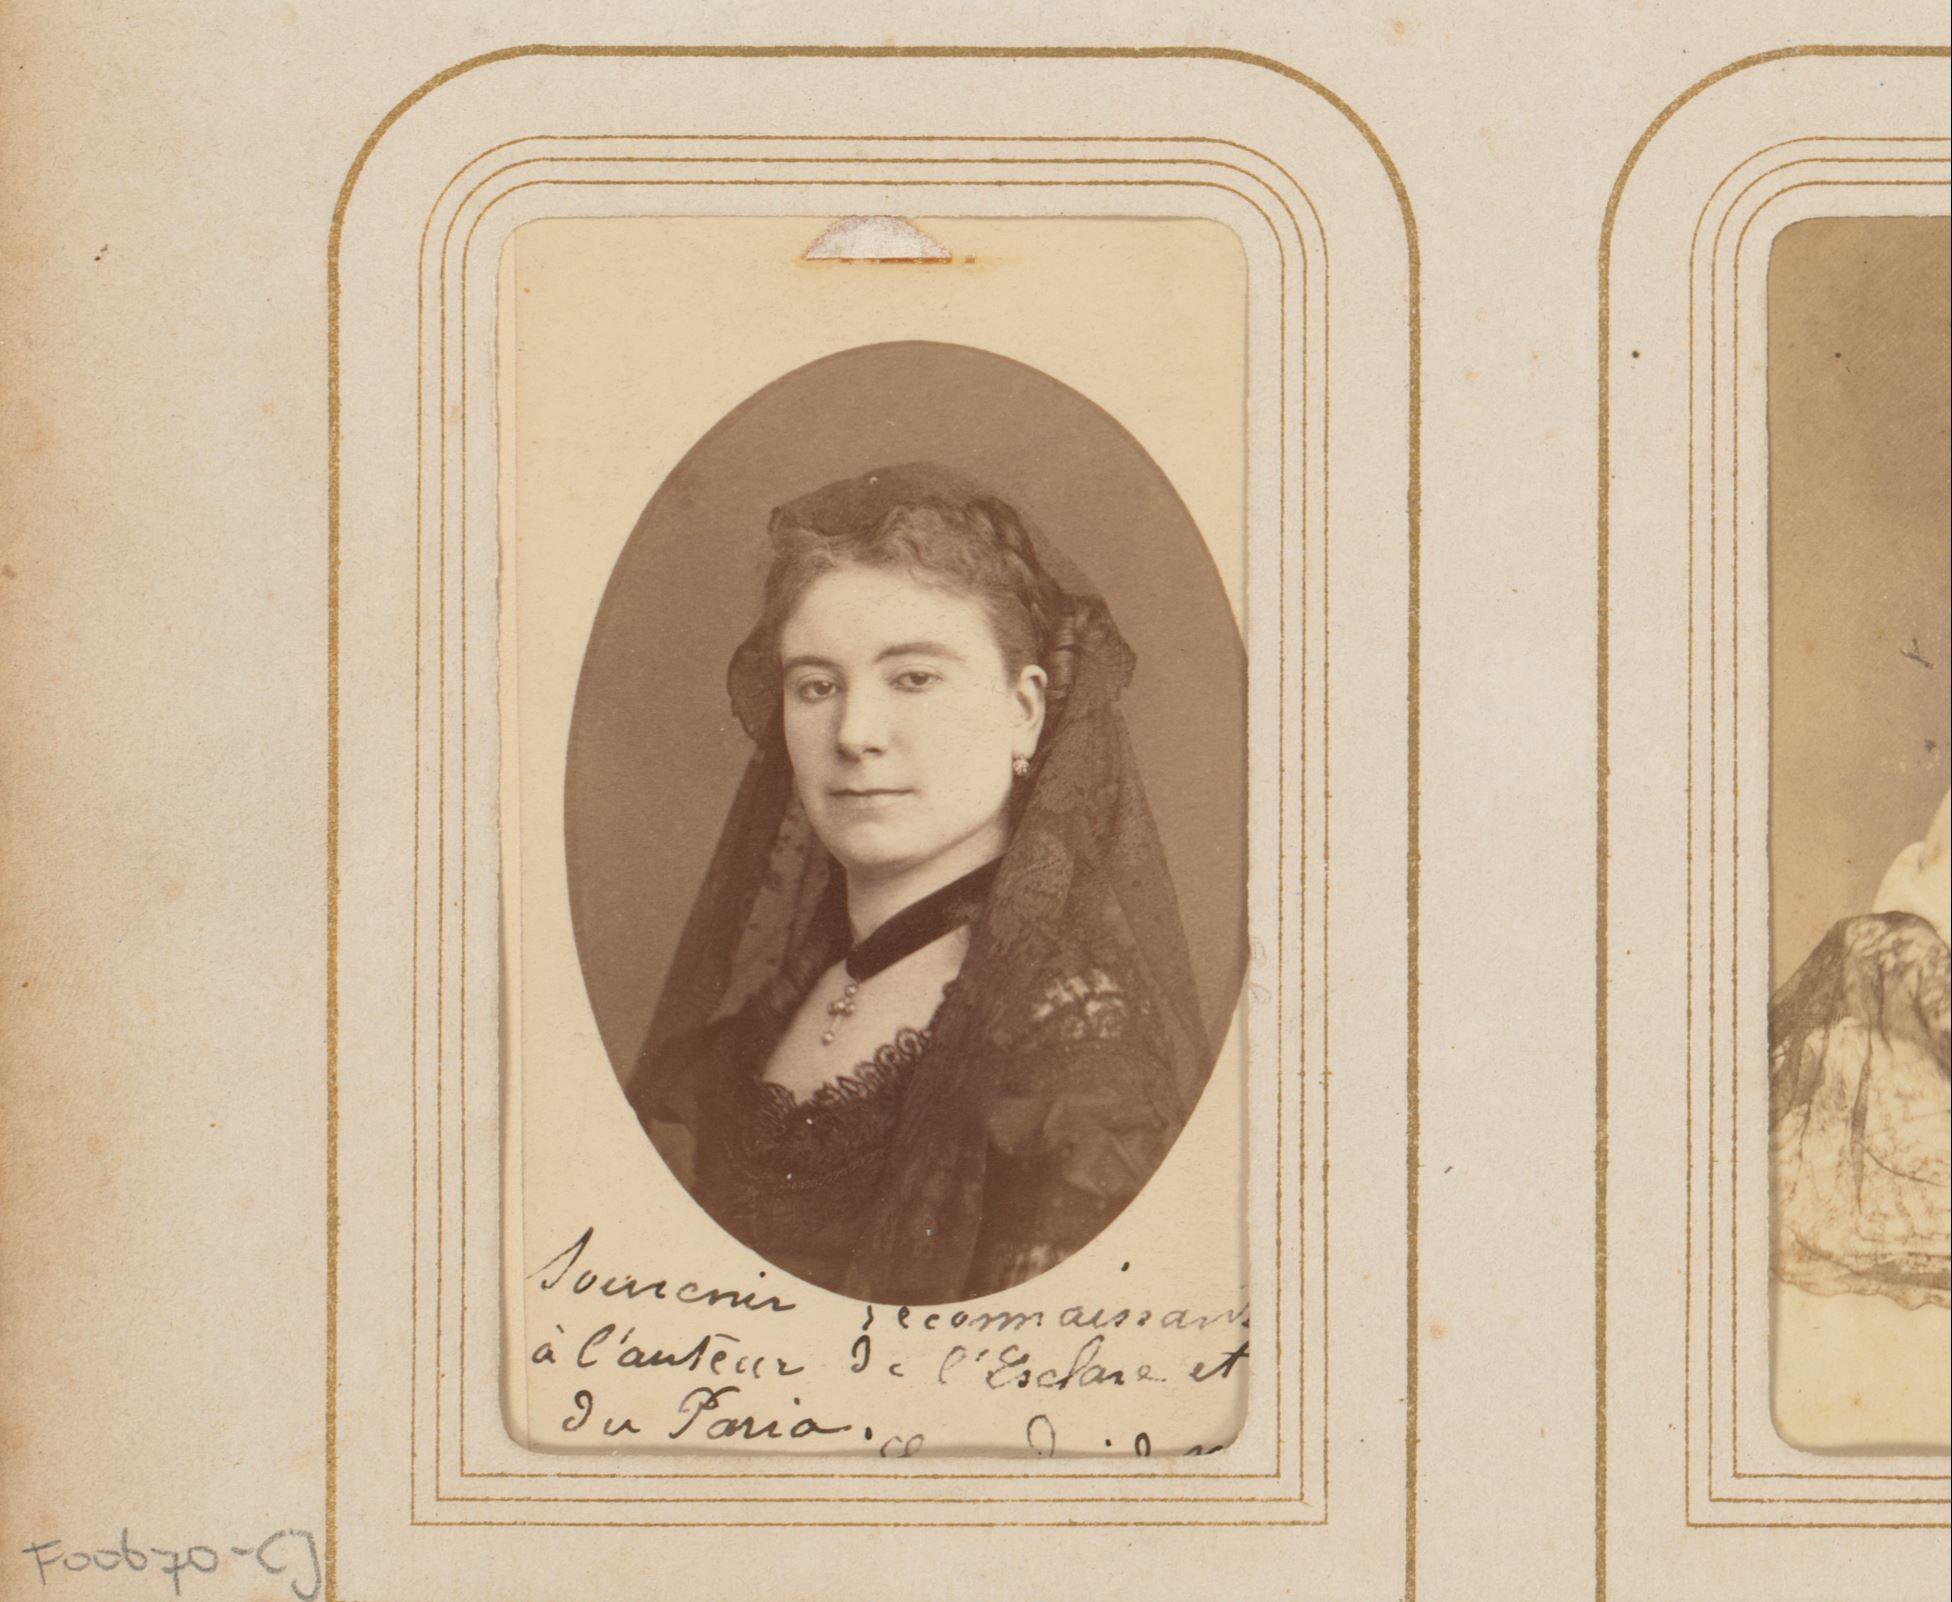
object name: album leaf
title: Portret van een vrouw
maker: joseph dupont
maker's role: fotograaf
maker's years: 1818-1901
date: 1870-1890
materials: cardboard, photographic support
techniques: albumen print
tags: historical persons - bb - woman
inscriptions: annotation: ‘[...] ecommaissant, à l'autresse [E. Madier de Monza]’, inscription: ‘J. Dupont/ Photographe du Roi/ [...]’, annotation: ‘[E. Madier de Monza] (Dupont)’